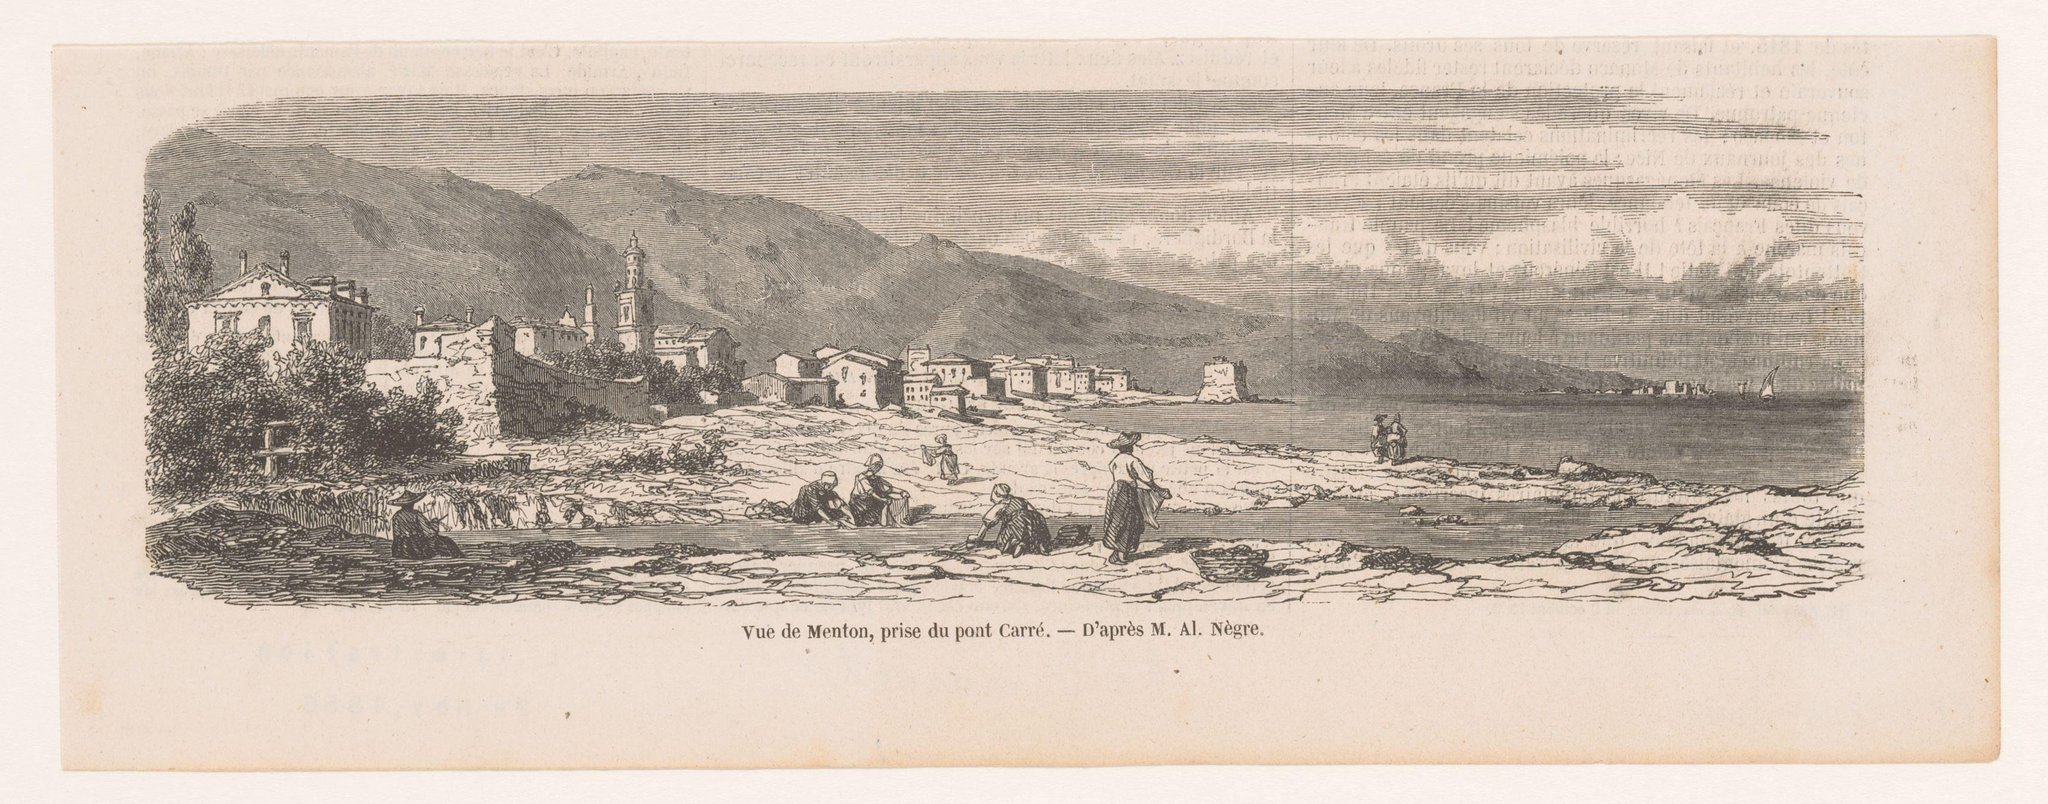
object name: print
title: Gezicht op Menton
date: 1856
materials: paper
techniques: letterpress printing, engraving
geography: paris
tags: city-view, and landscape with man-made constructions, coast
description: Prent uit: L'Illustration, vol. 28, nr. 717, 22 november 1856, p. 333.